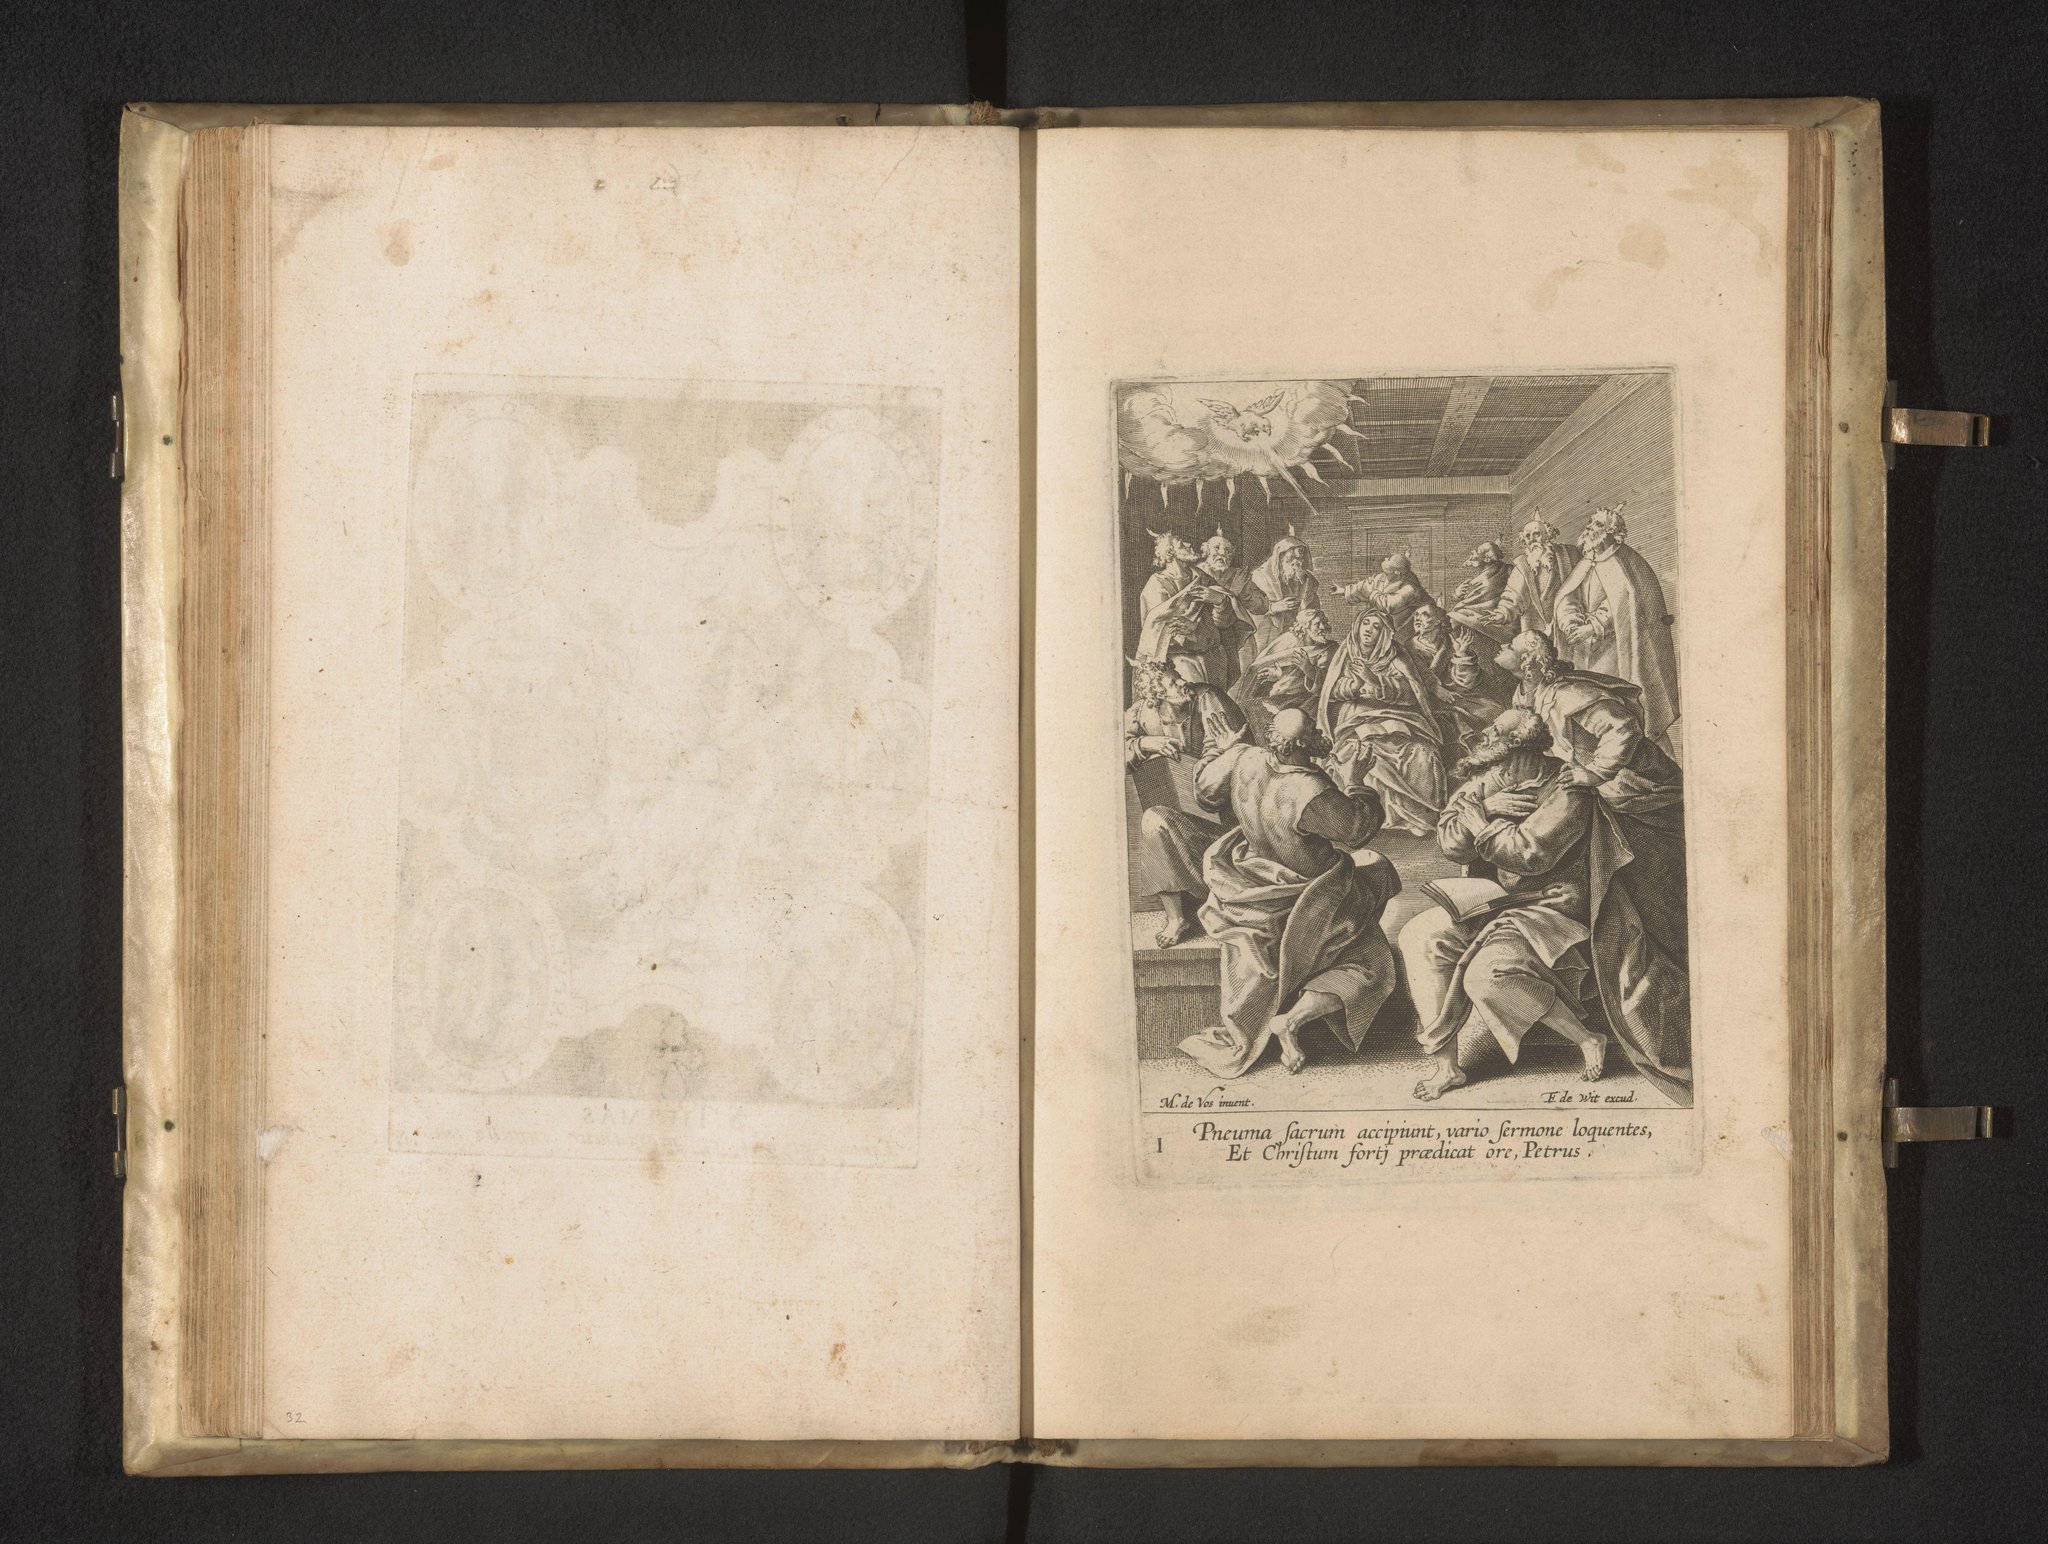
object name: print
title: Pinksteren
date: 1580-1585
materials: paper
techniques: engraving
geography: amsterdam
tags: the holy ghost descends upon the gentiles after peter's prayer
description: Pinksteren: Uitstorting van de Heilige Geest. Linksonder genummerd: I. Onderaan in de marge een tweeregelig onderschrift in het Latijn. Onderdeel van een serie van twaalf voorstellingen van de Handelingen van de apostelen. Onderdeel van een album met voornamelijk christelijke voorstellingen.